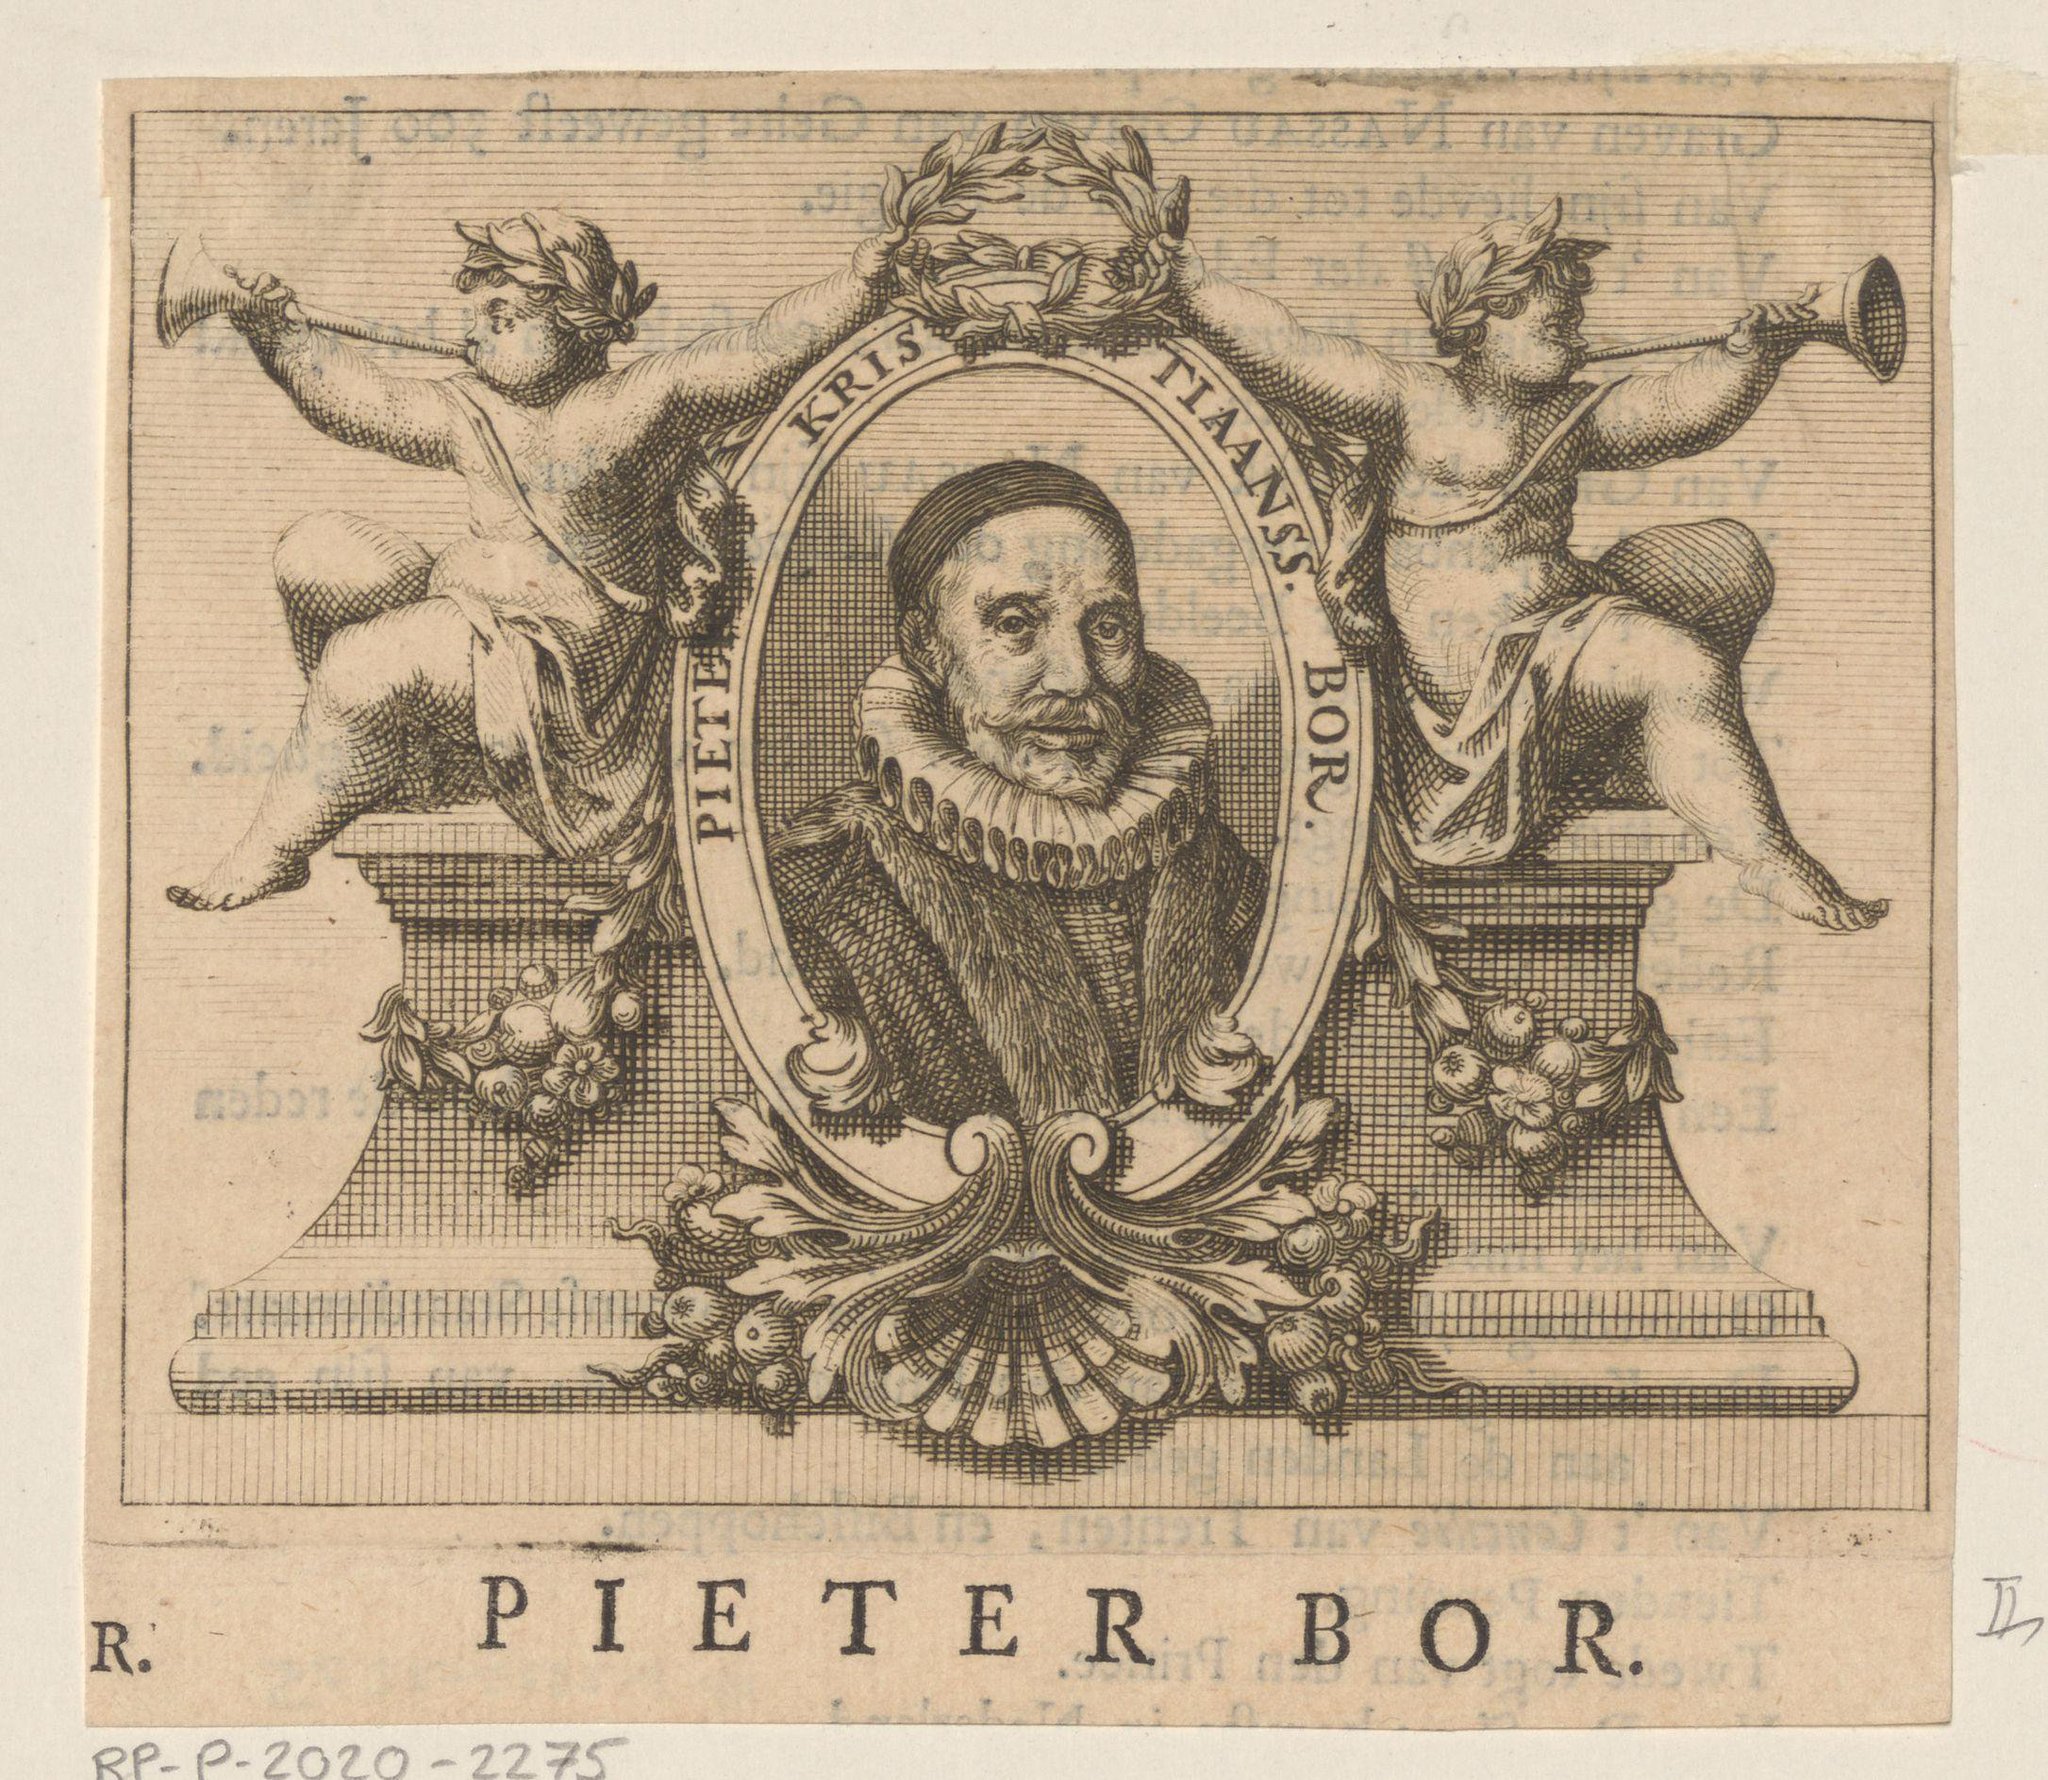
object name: print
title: Portret van Pieter Christiaansz. Bor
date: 1701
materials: paper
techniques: engraving, etching, letterpress printing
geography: leiden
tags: utrecht, haarlem, honouring the artist with laurel wreath, historical persons, portrait of a writer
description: Prent uit: Pars, Adriaan. Index Batavicus, of naamrol van de Batavise en Hollandse schrijvers (...). Leiden: Abraham de Swart, 1701, p. 258.